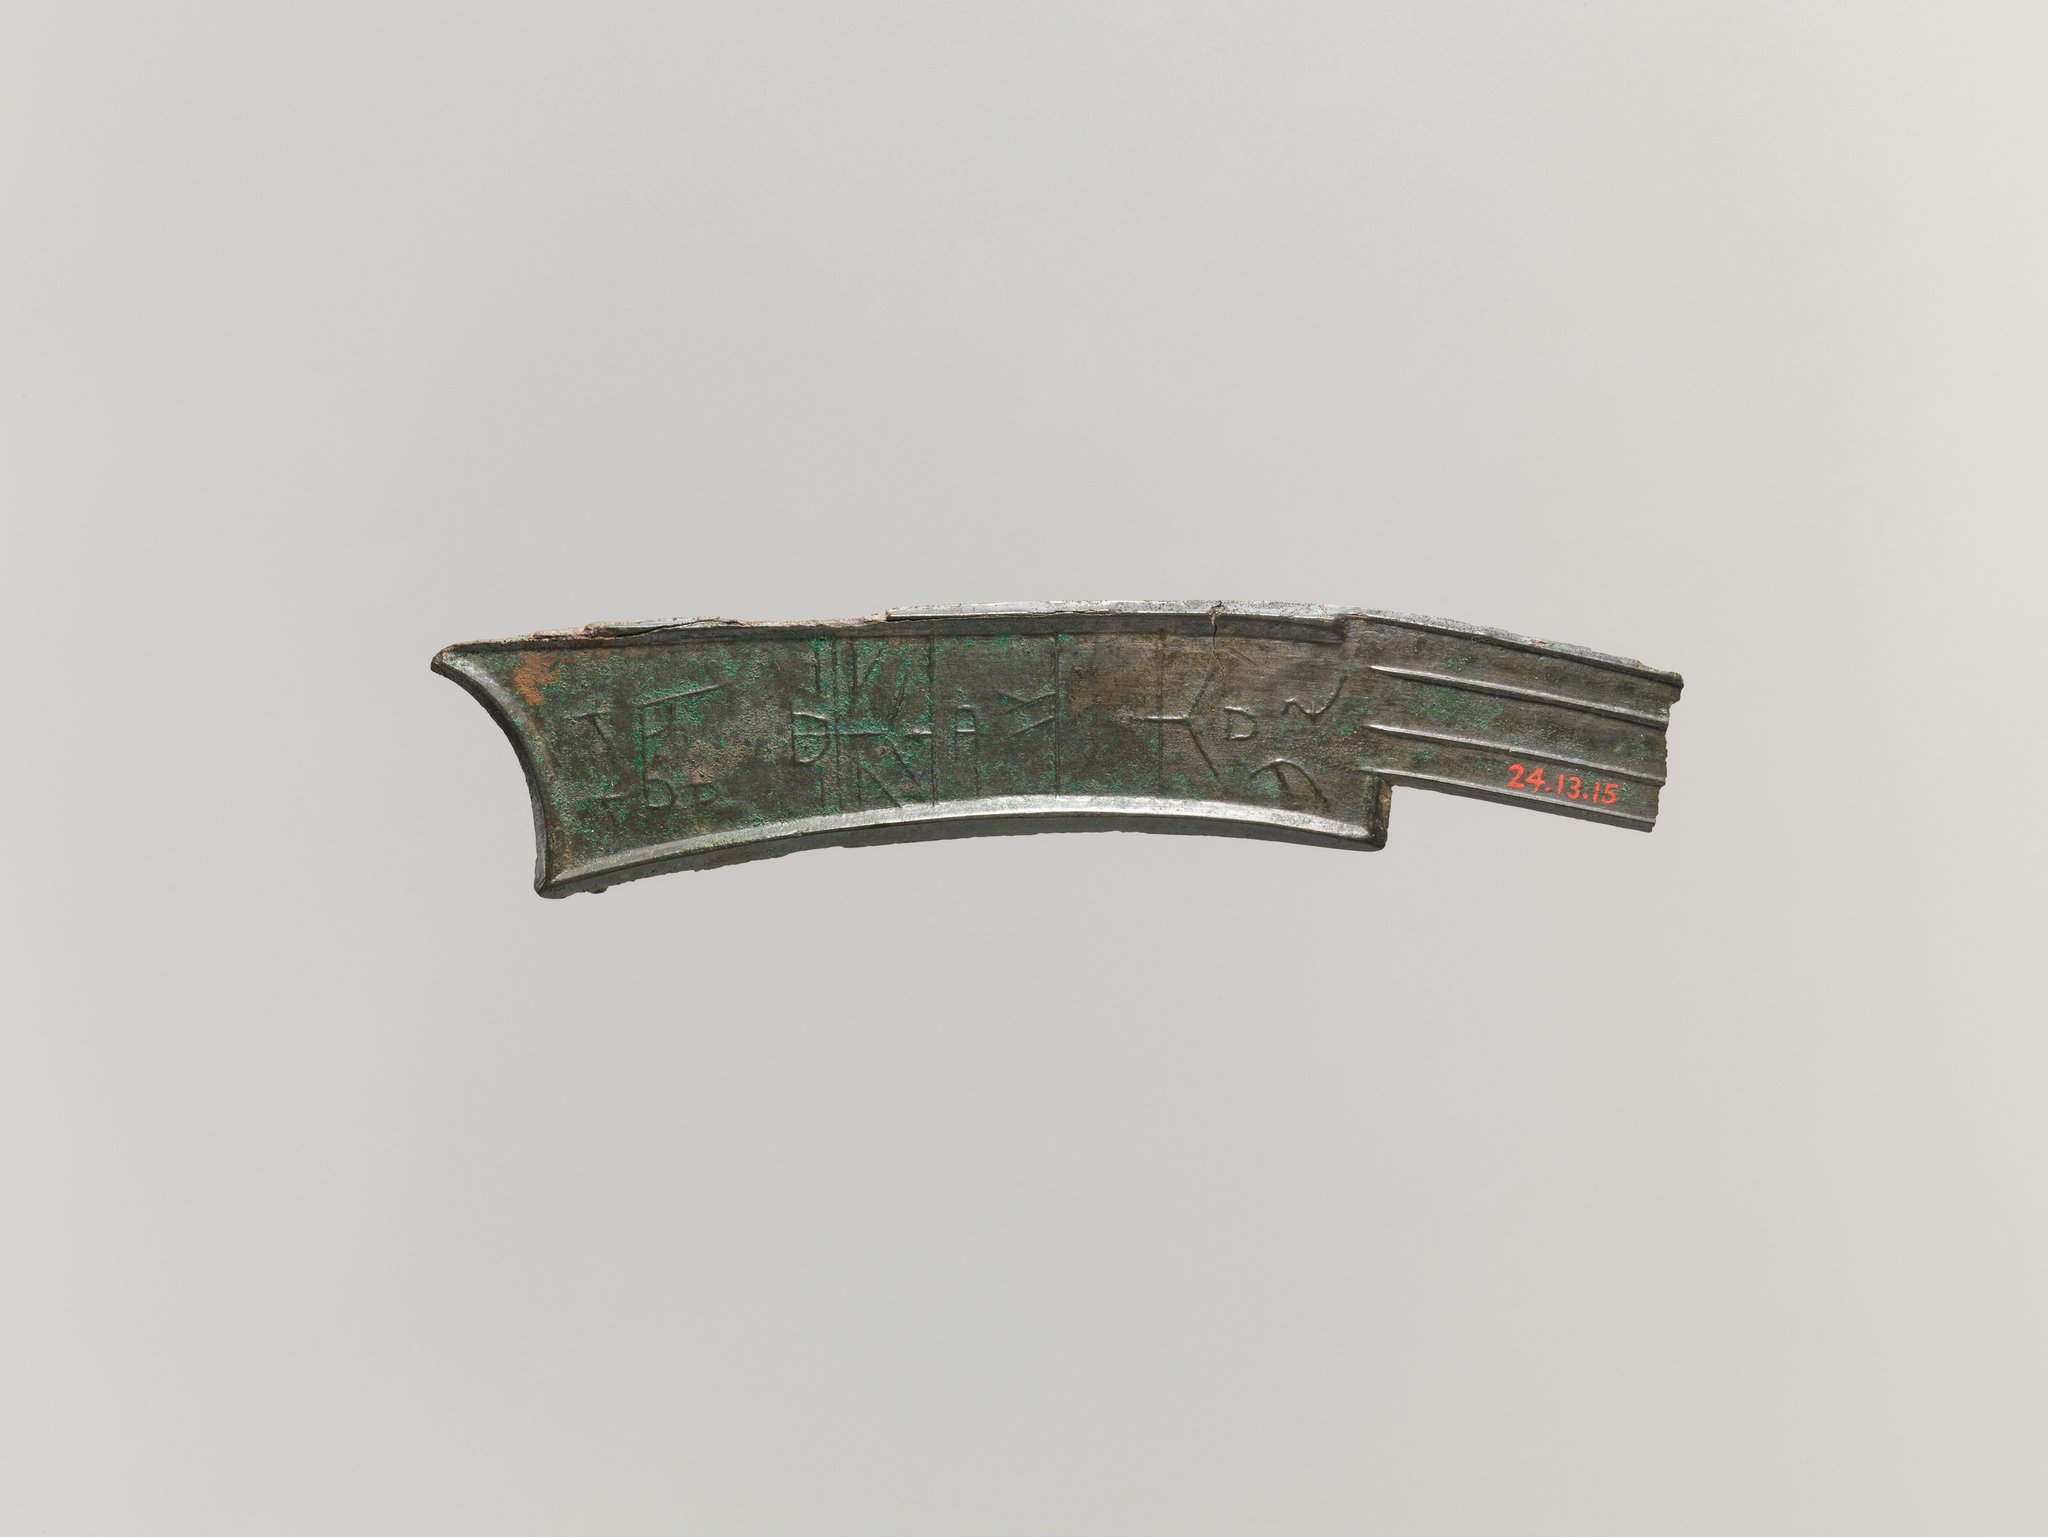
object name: knife coin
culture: chinese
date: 206 BCE-220 CE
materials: bronze